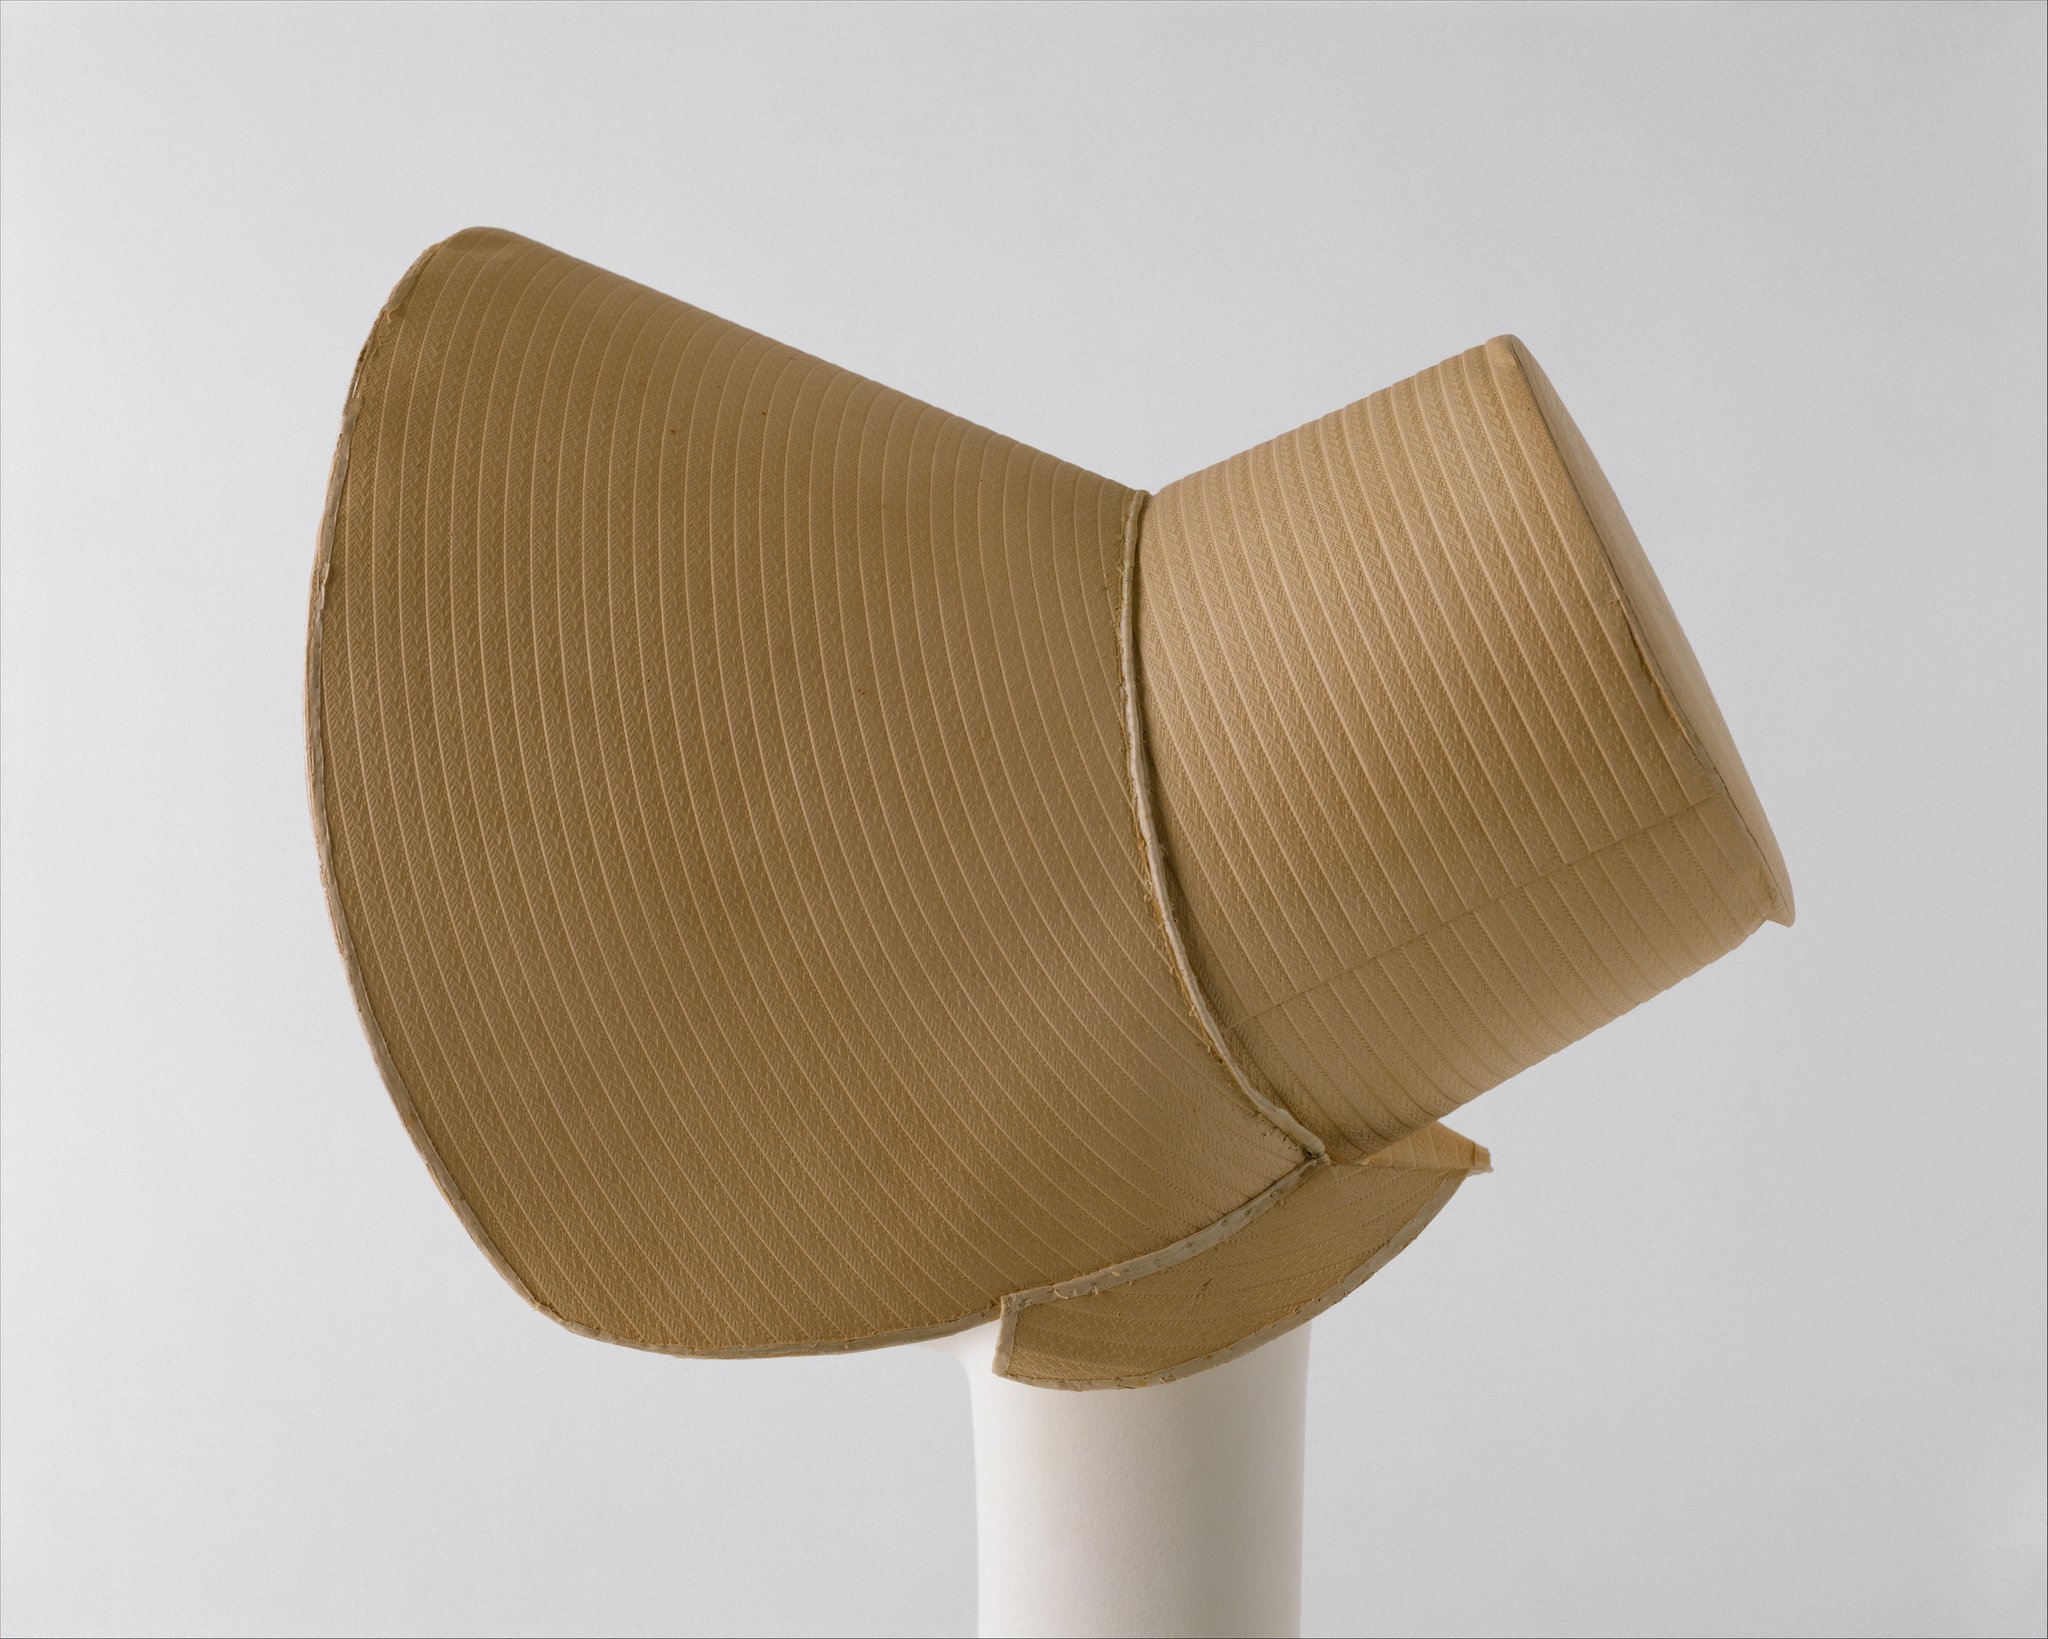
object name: bonnet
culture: american or european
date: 1830-1835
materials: paper, silk